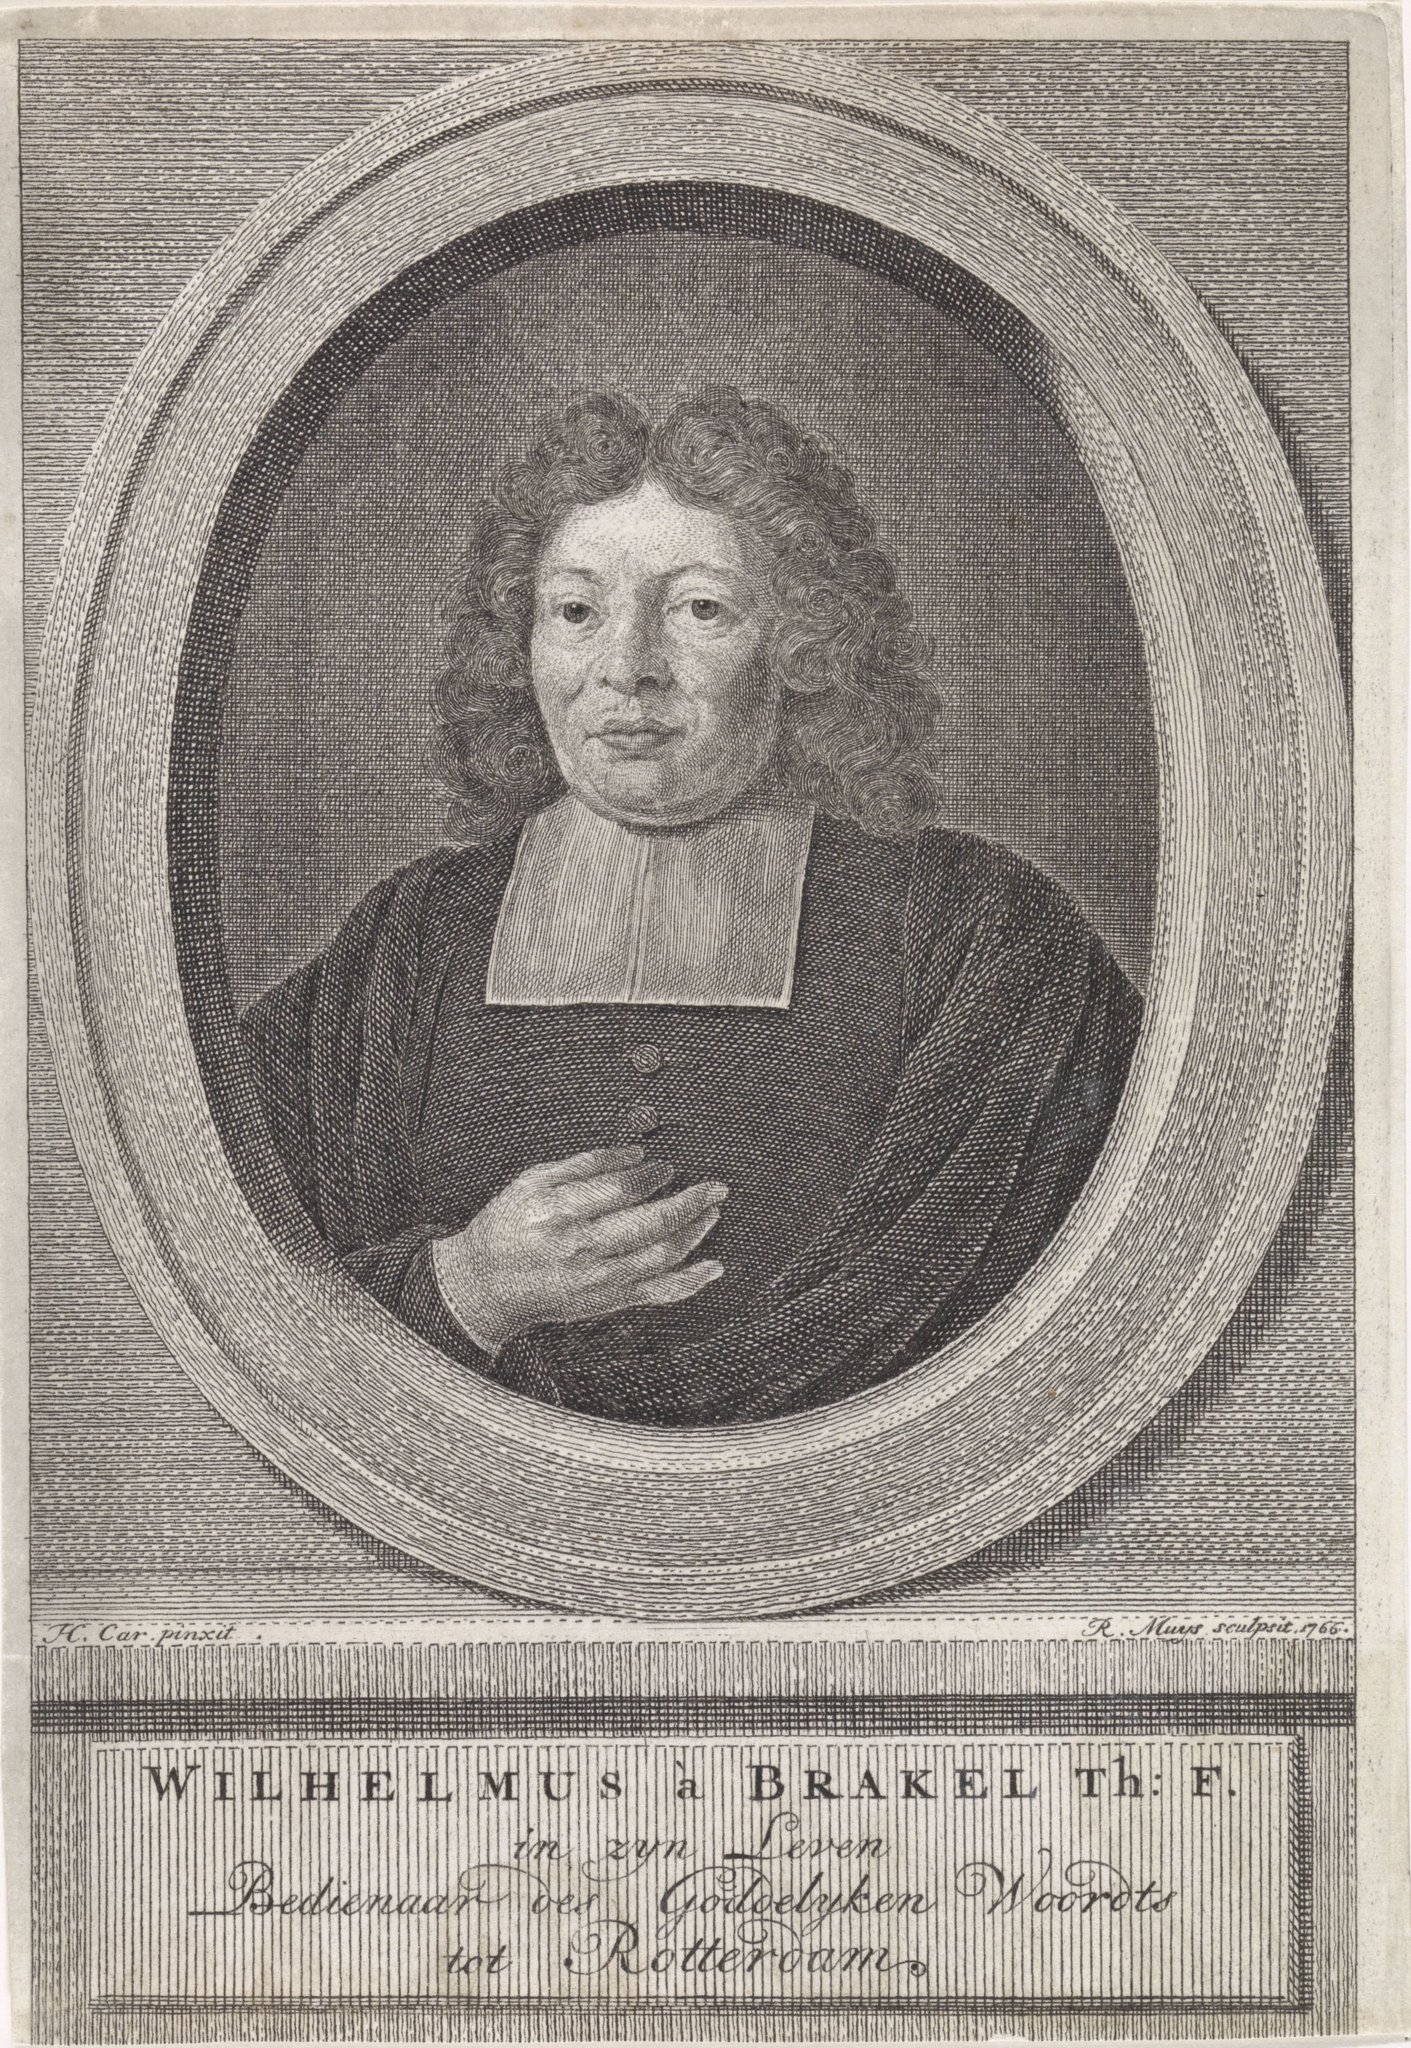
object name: print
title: Wilhelmus à Brakel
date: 1766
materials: paper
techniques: engraving, etching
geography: rotterdam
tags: rotterdam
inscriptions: collector's mark: Lugt 2228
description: Buste van Willem van Brakel, predikant te Rotterdam, licht naar links in ovaal.